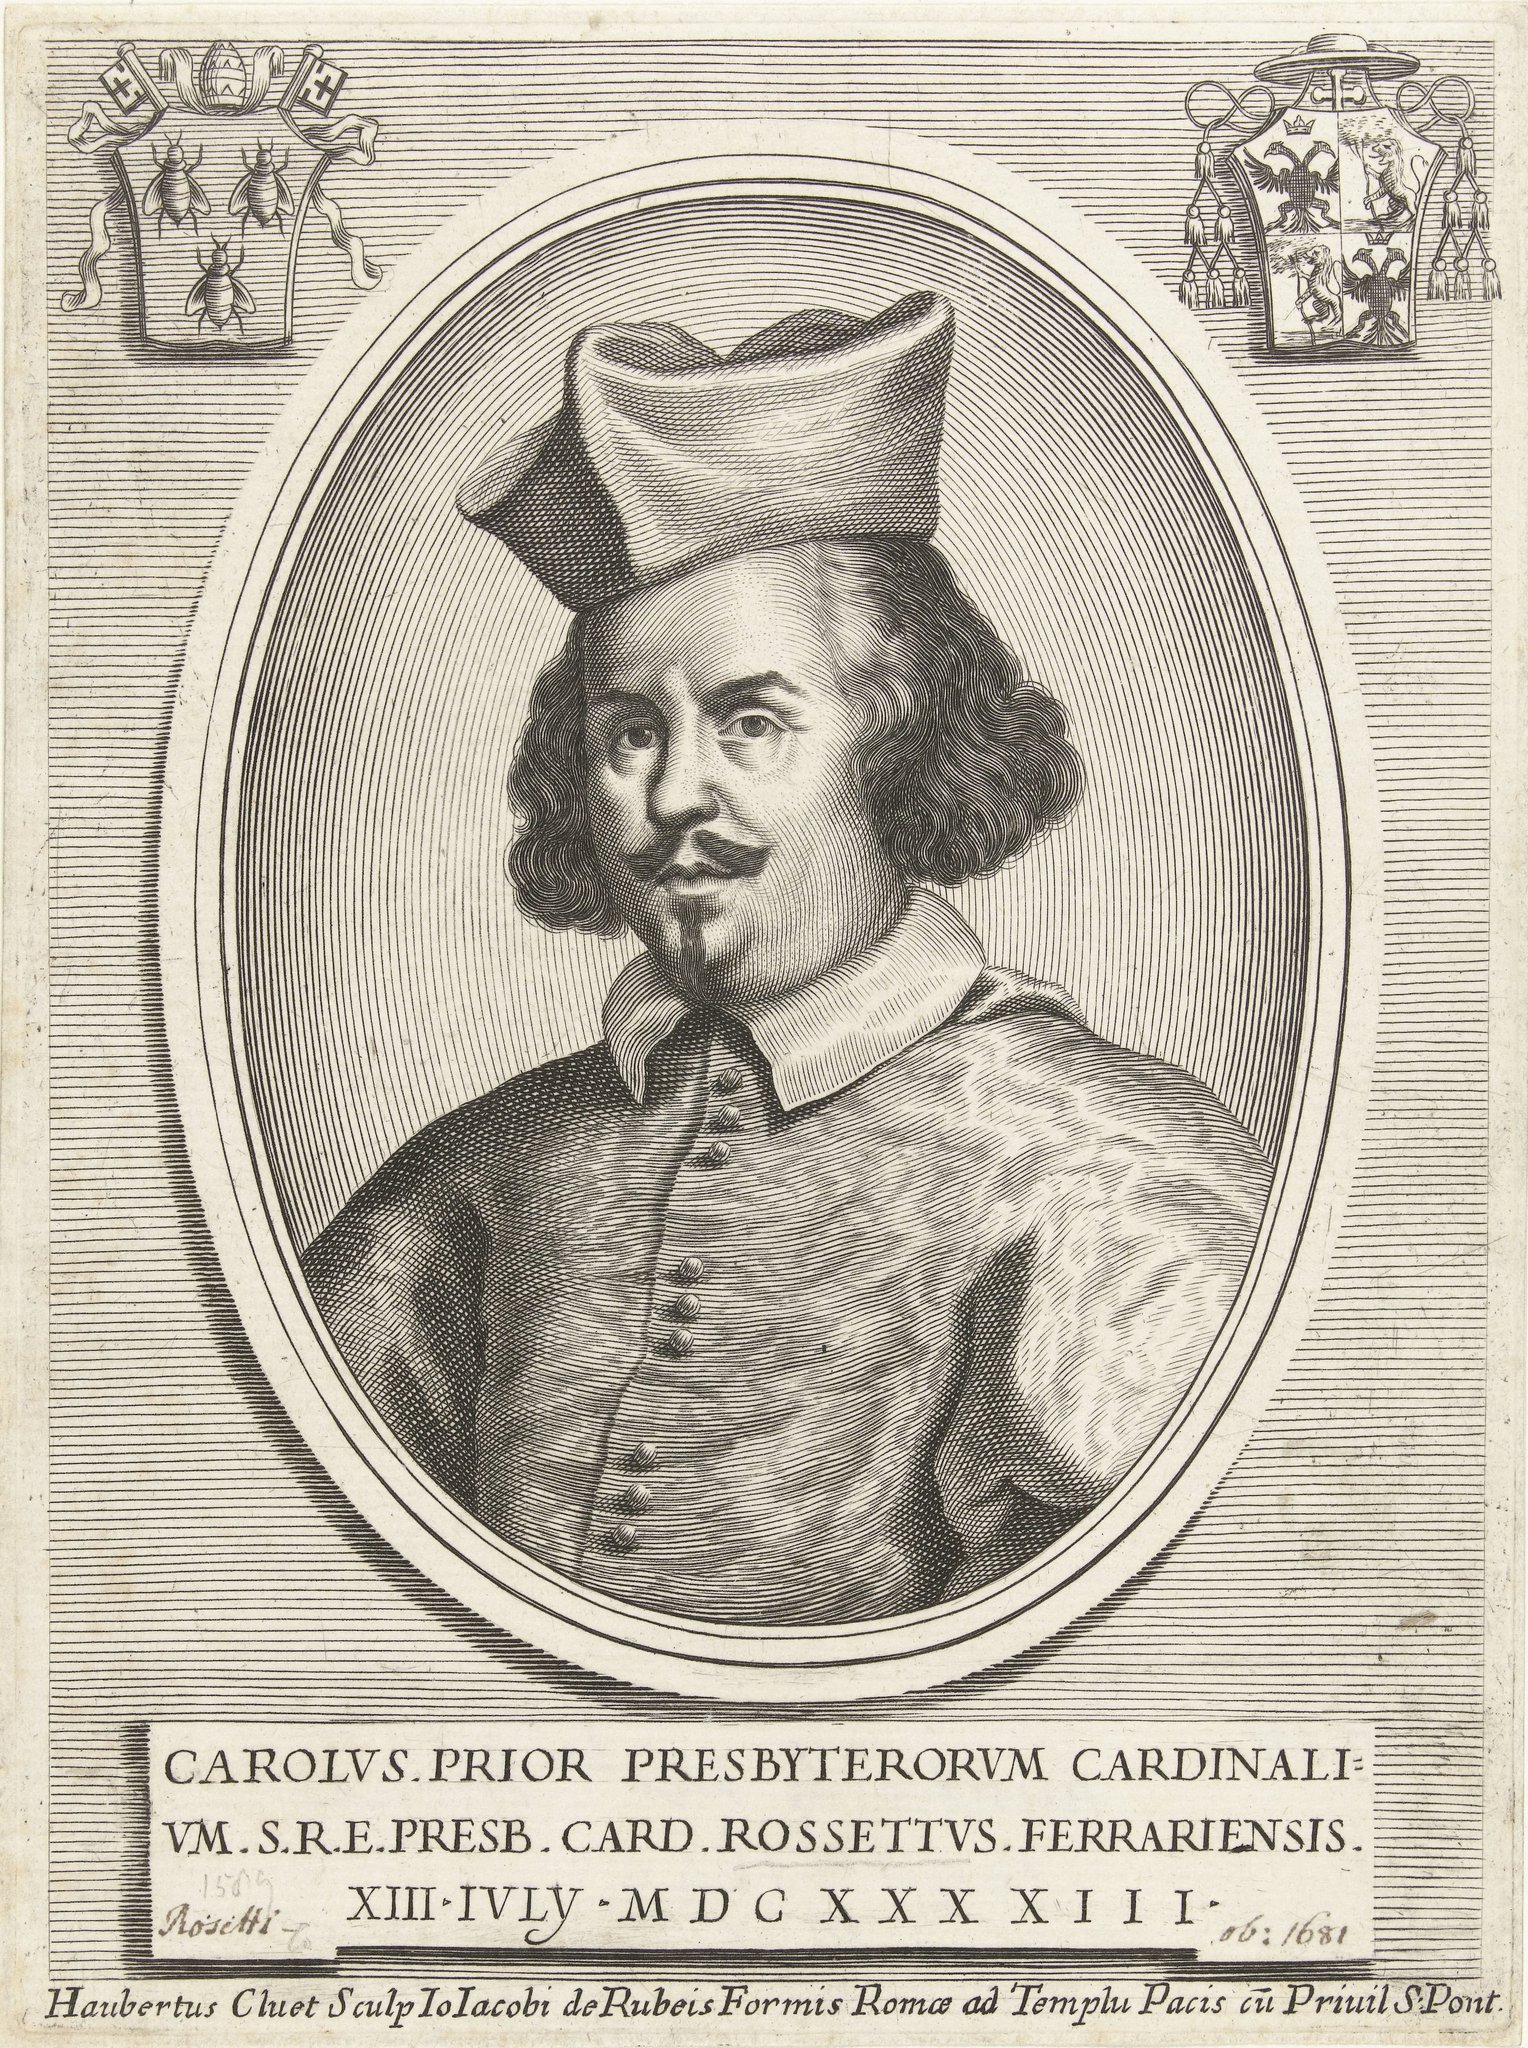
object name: print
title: Effigies cardinalium nunc viventium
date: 1646-1679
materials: paper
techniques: engraving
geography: rome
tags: kardinaal, carlo rossetti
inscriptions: collector's mark: Lugt 2228, caption: ‘Roseti ob: 1681’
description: Portret in ovale lijst van kardinaal Carlo Rossetti. Buste naar links. Bovenaan links het wapen van paus Urbanuss VIII, bovenaan rechts het wapen van kardinaal Carlo Rossetti. De prent heeft een Latijns onderschrift met gegevens over de geportretteerde.